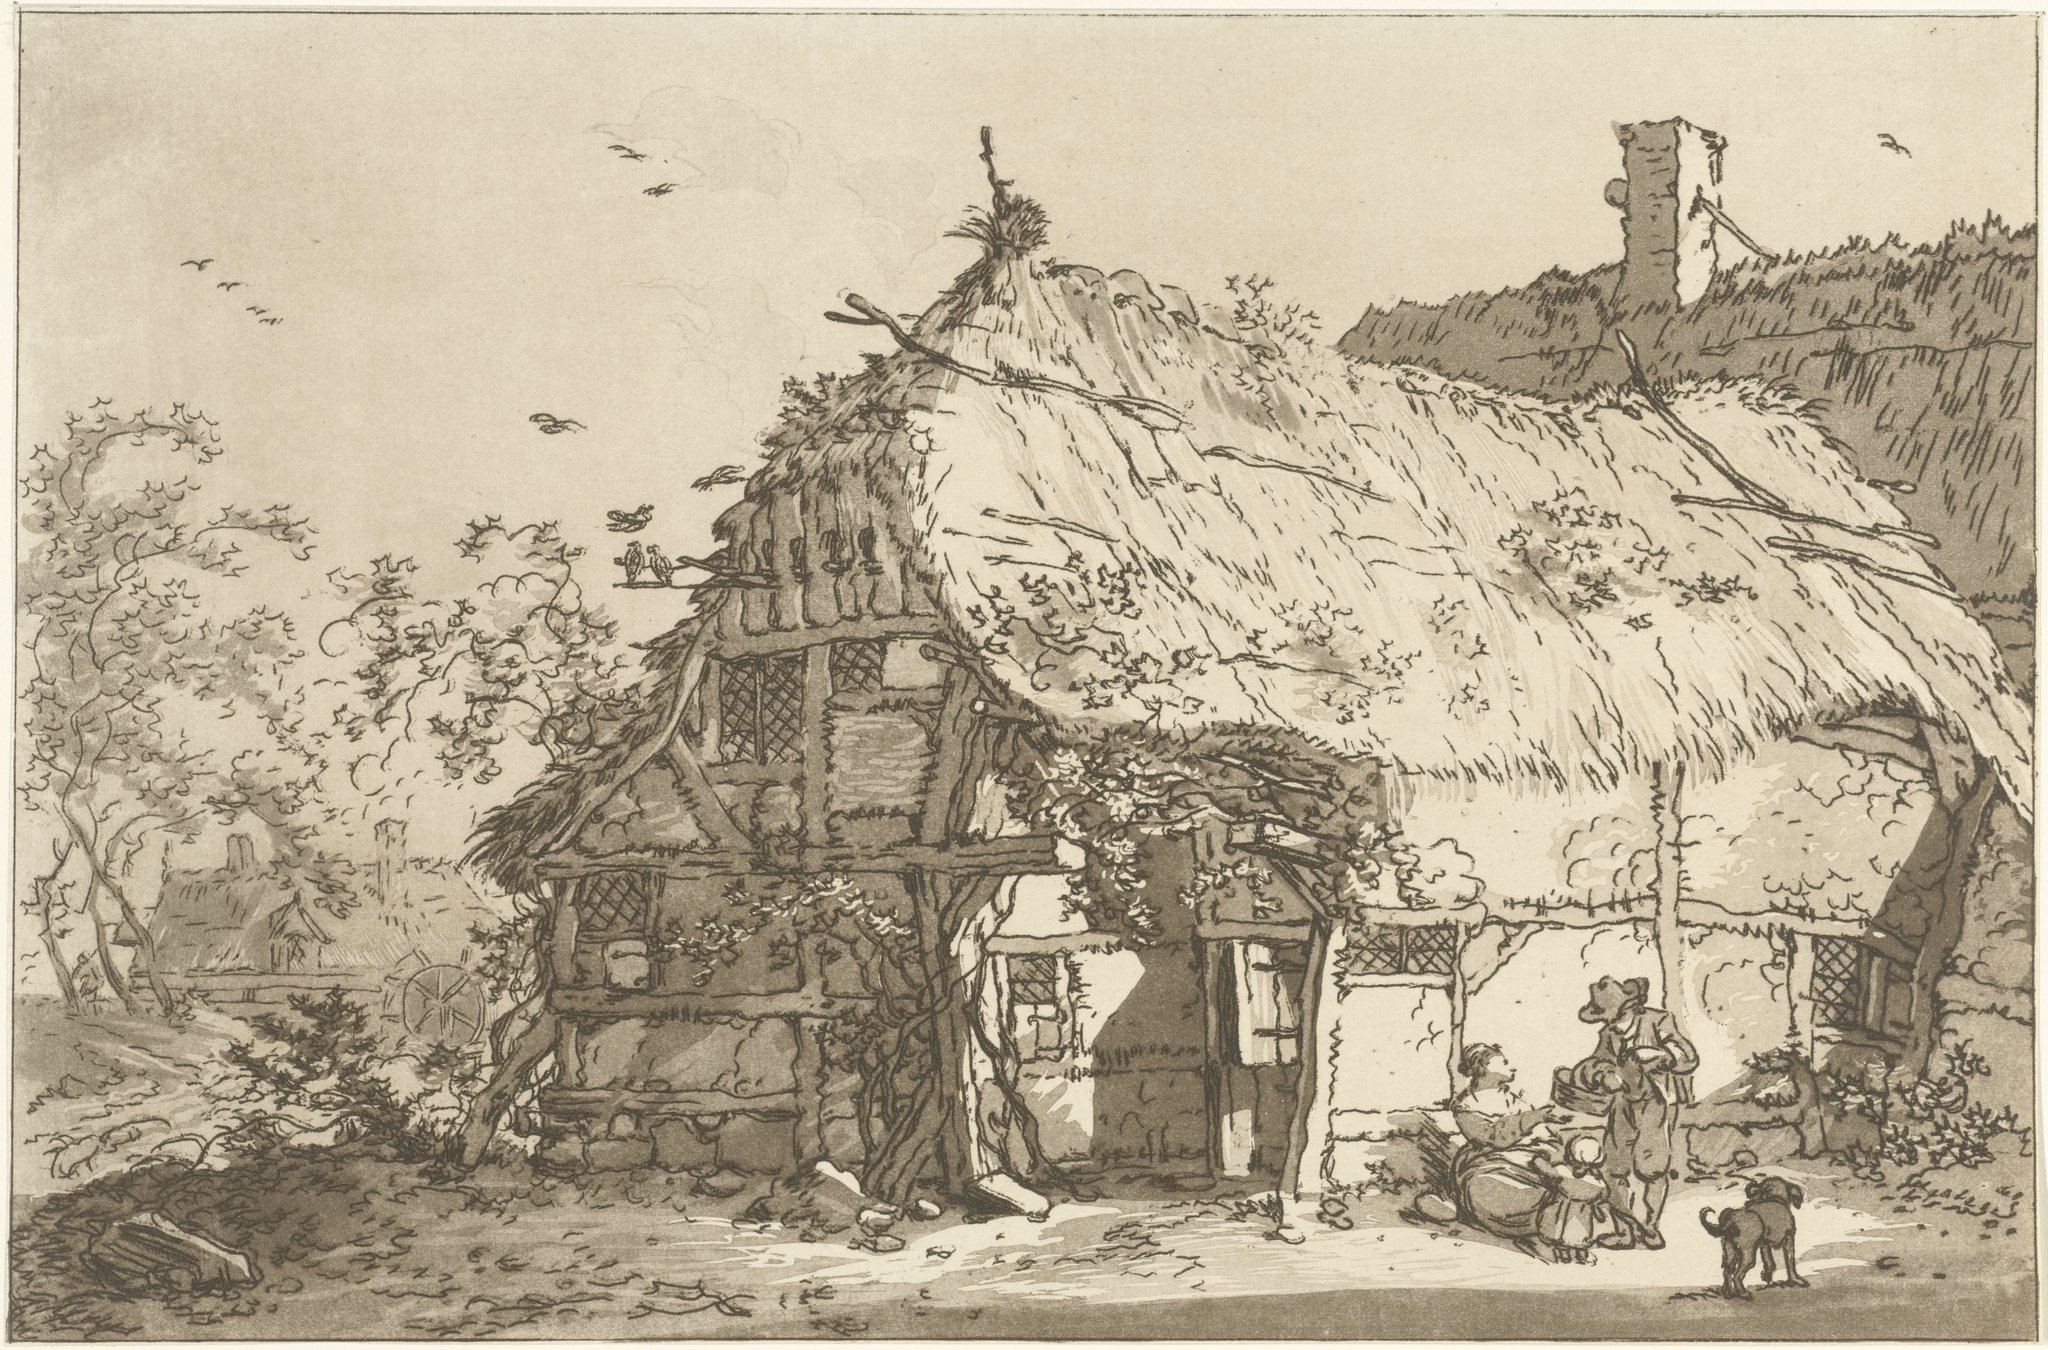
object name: print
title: Twelve designs Calculated for the Use of those who are Learning to Draw Landscape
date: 1789-1793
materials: paper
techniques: aquatint, etching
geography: london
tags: family life at home, farm (building), dog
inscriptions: collector's mark: Lugt 2228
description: Een boerderij met een dak van stro. Op het erf een gezin met een vrouw, een kind en een man met een mand aan de arm. Daarbij een hond.